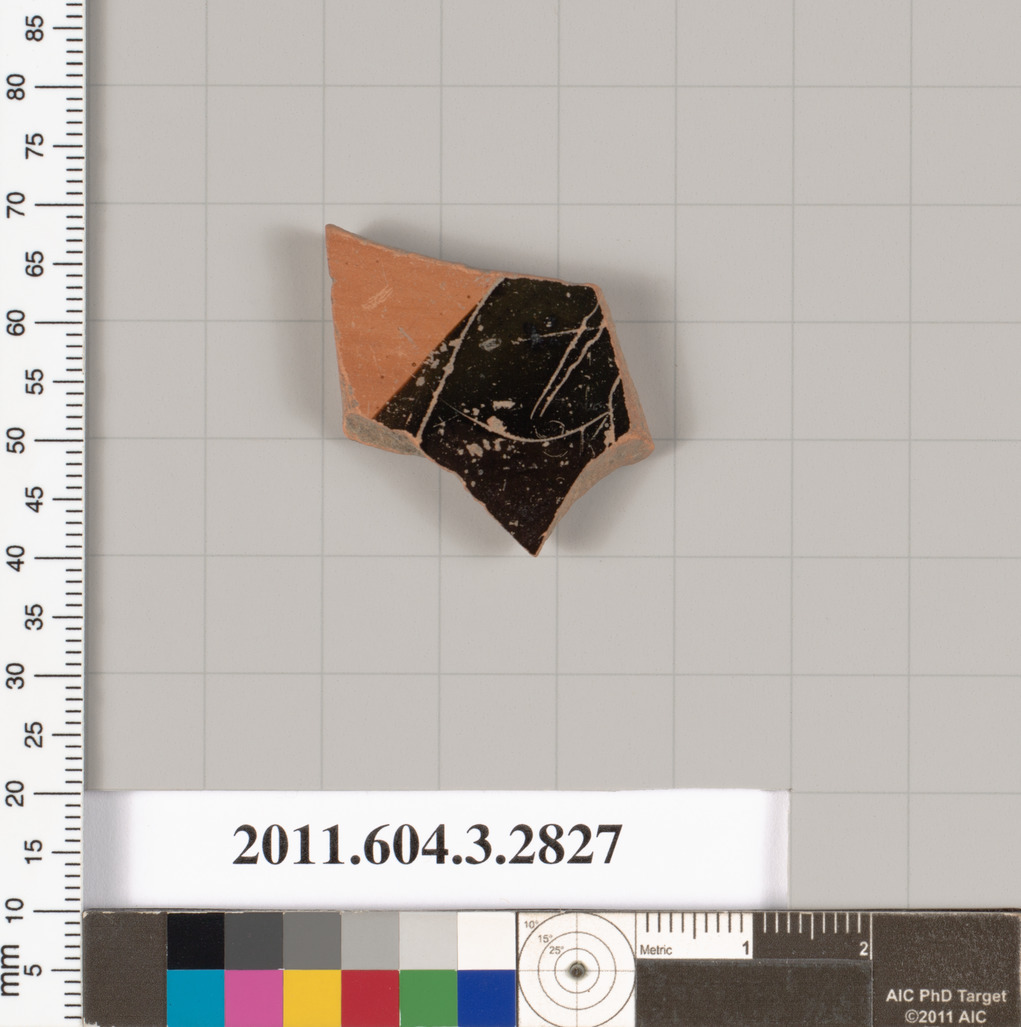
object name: undetermined closed shape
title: Terracotta fragment of a closed shape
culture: greek, attic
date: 534-468 BCE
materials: terracotta